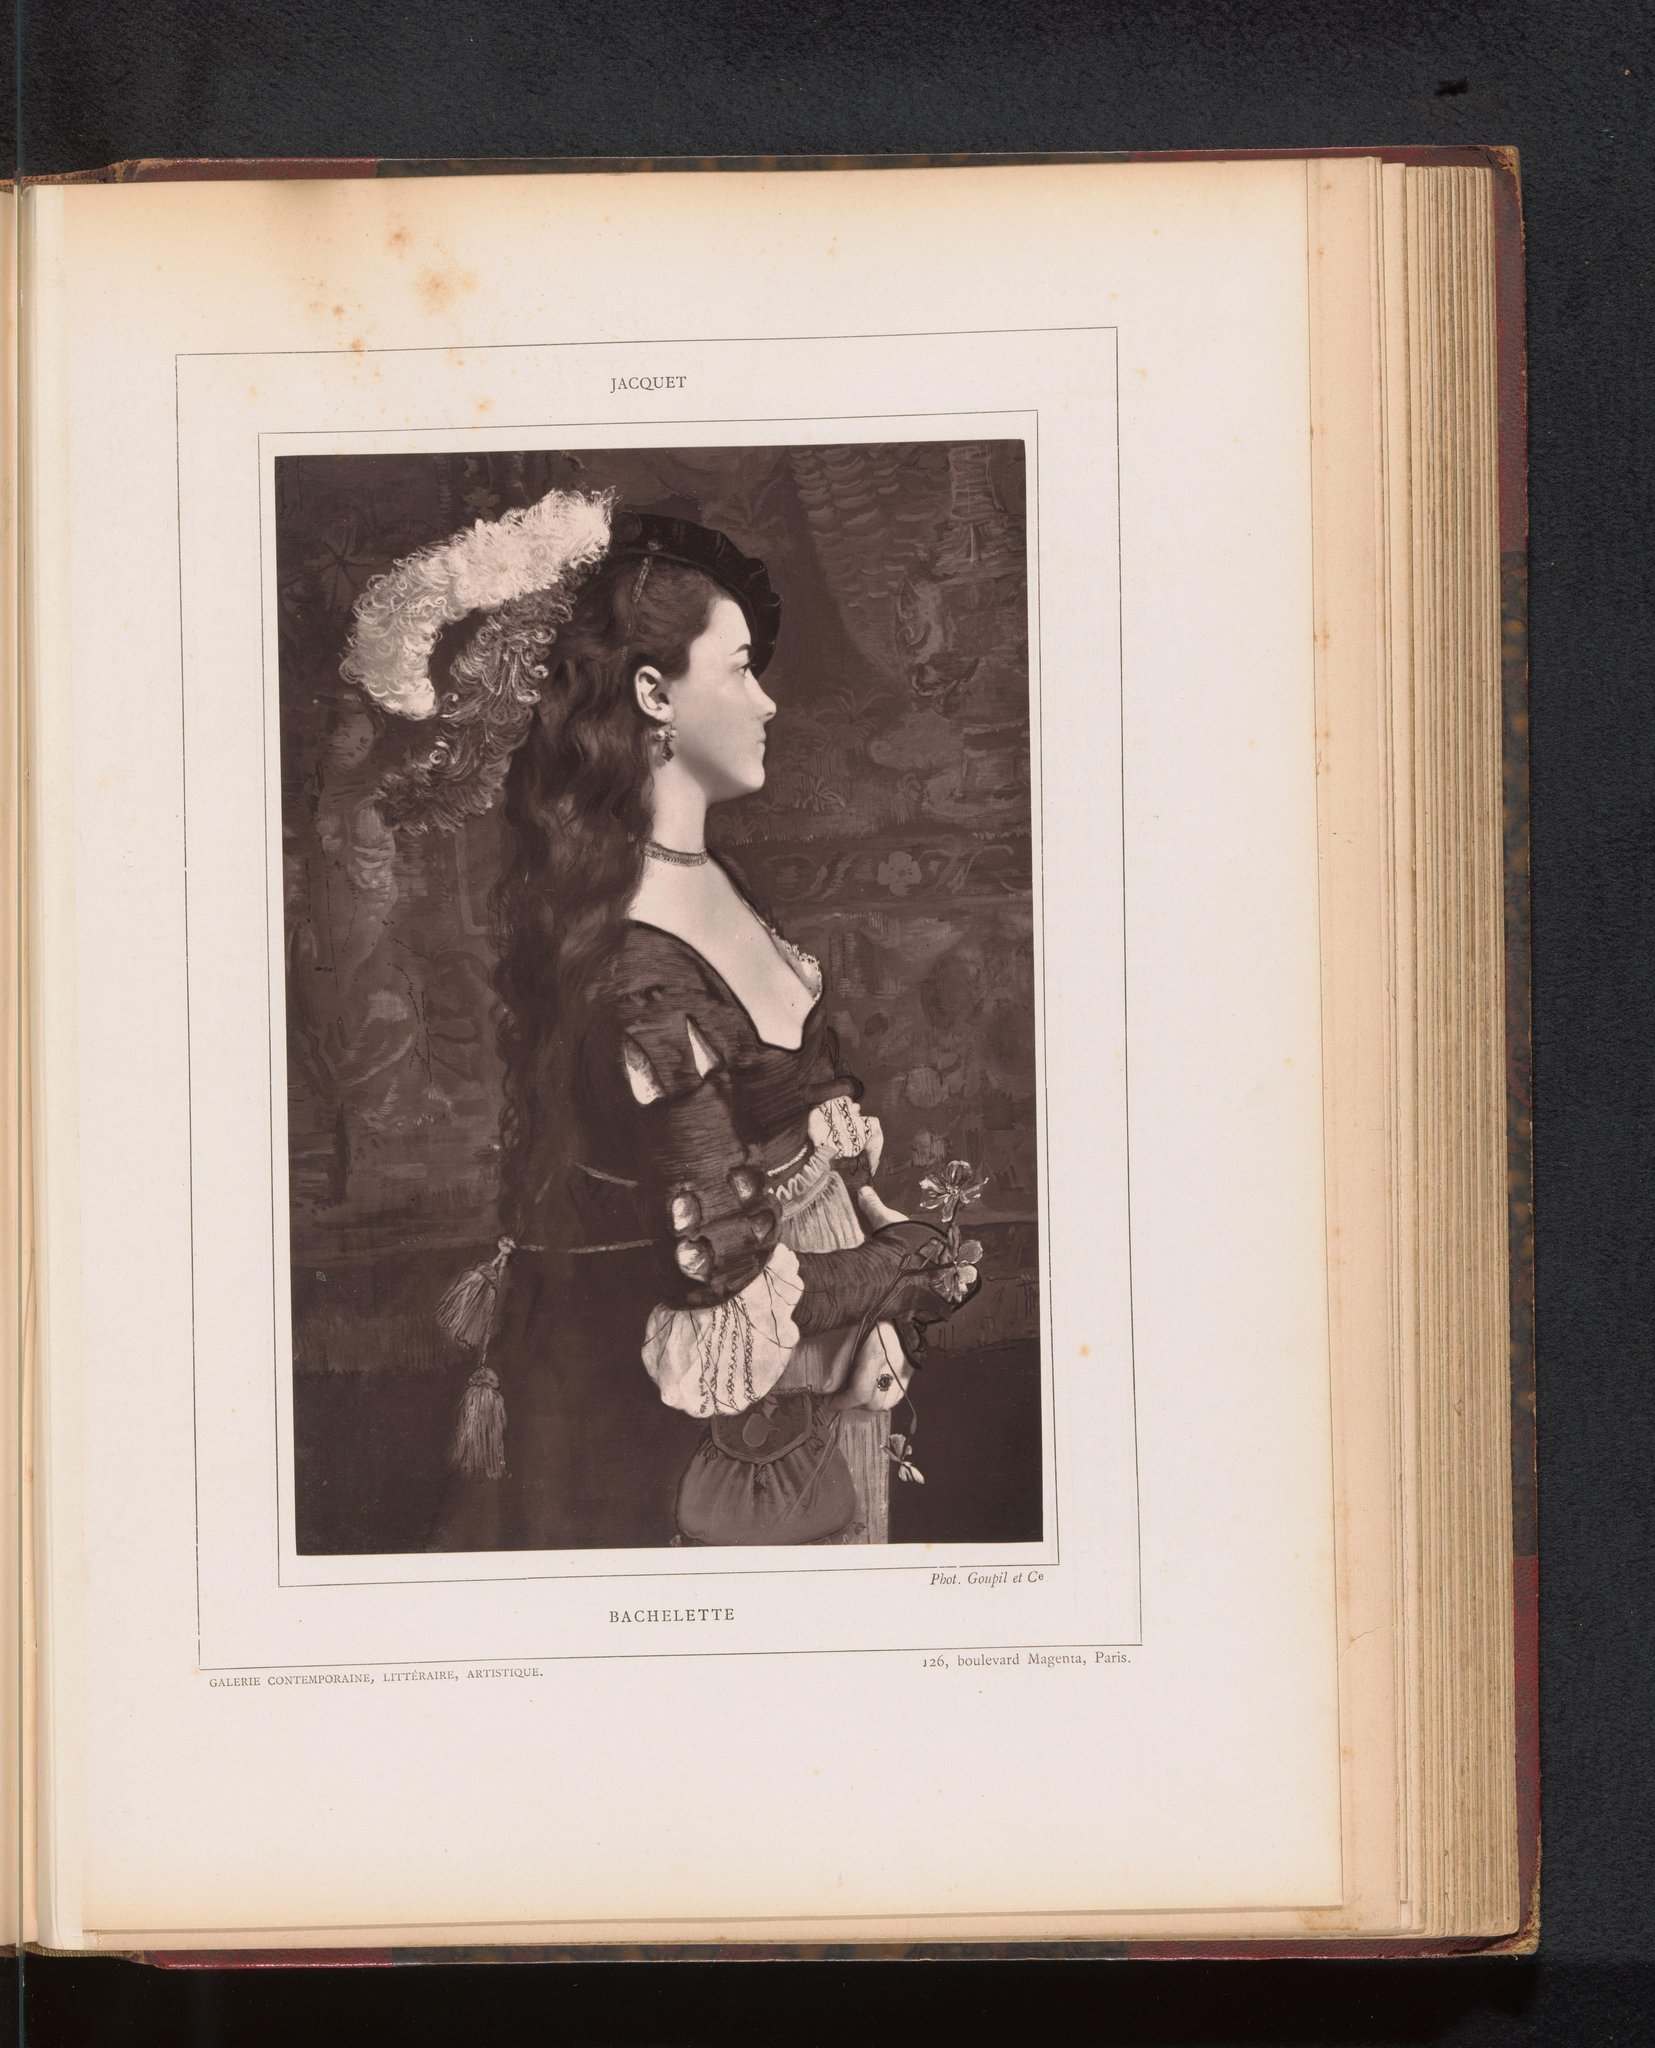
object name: photomechanical print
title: Bachelette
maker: gustave jean jacquet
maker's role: painter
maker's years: 1846-1909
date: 1873-1878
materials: paper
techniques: woodburytype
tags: adolescent, young woman, maiden, historical persons - bb - woman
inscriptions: inscription: ‘Galerie Contemporaine, Littéraire, Artistique/ 126, boulevard Magenta, Paris.’